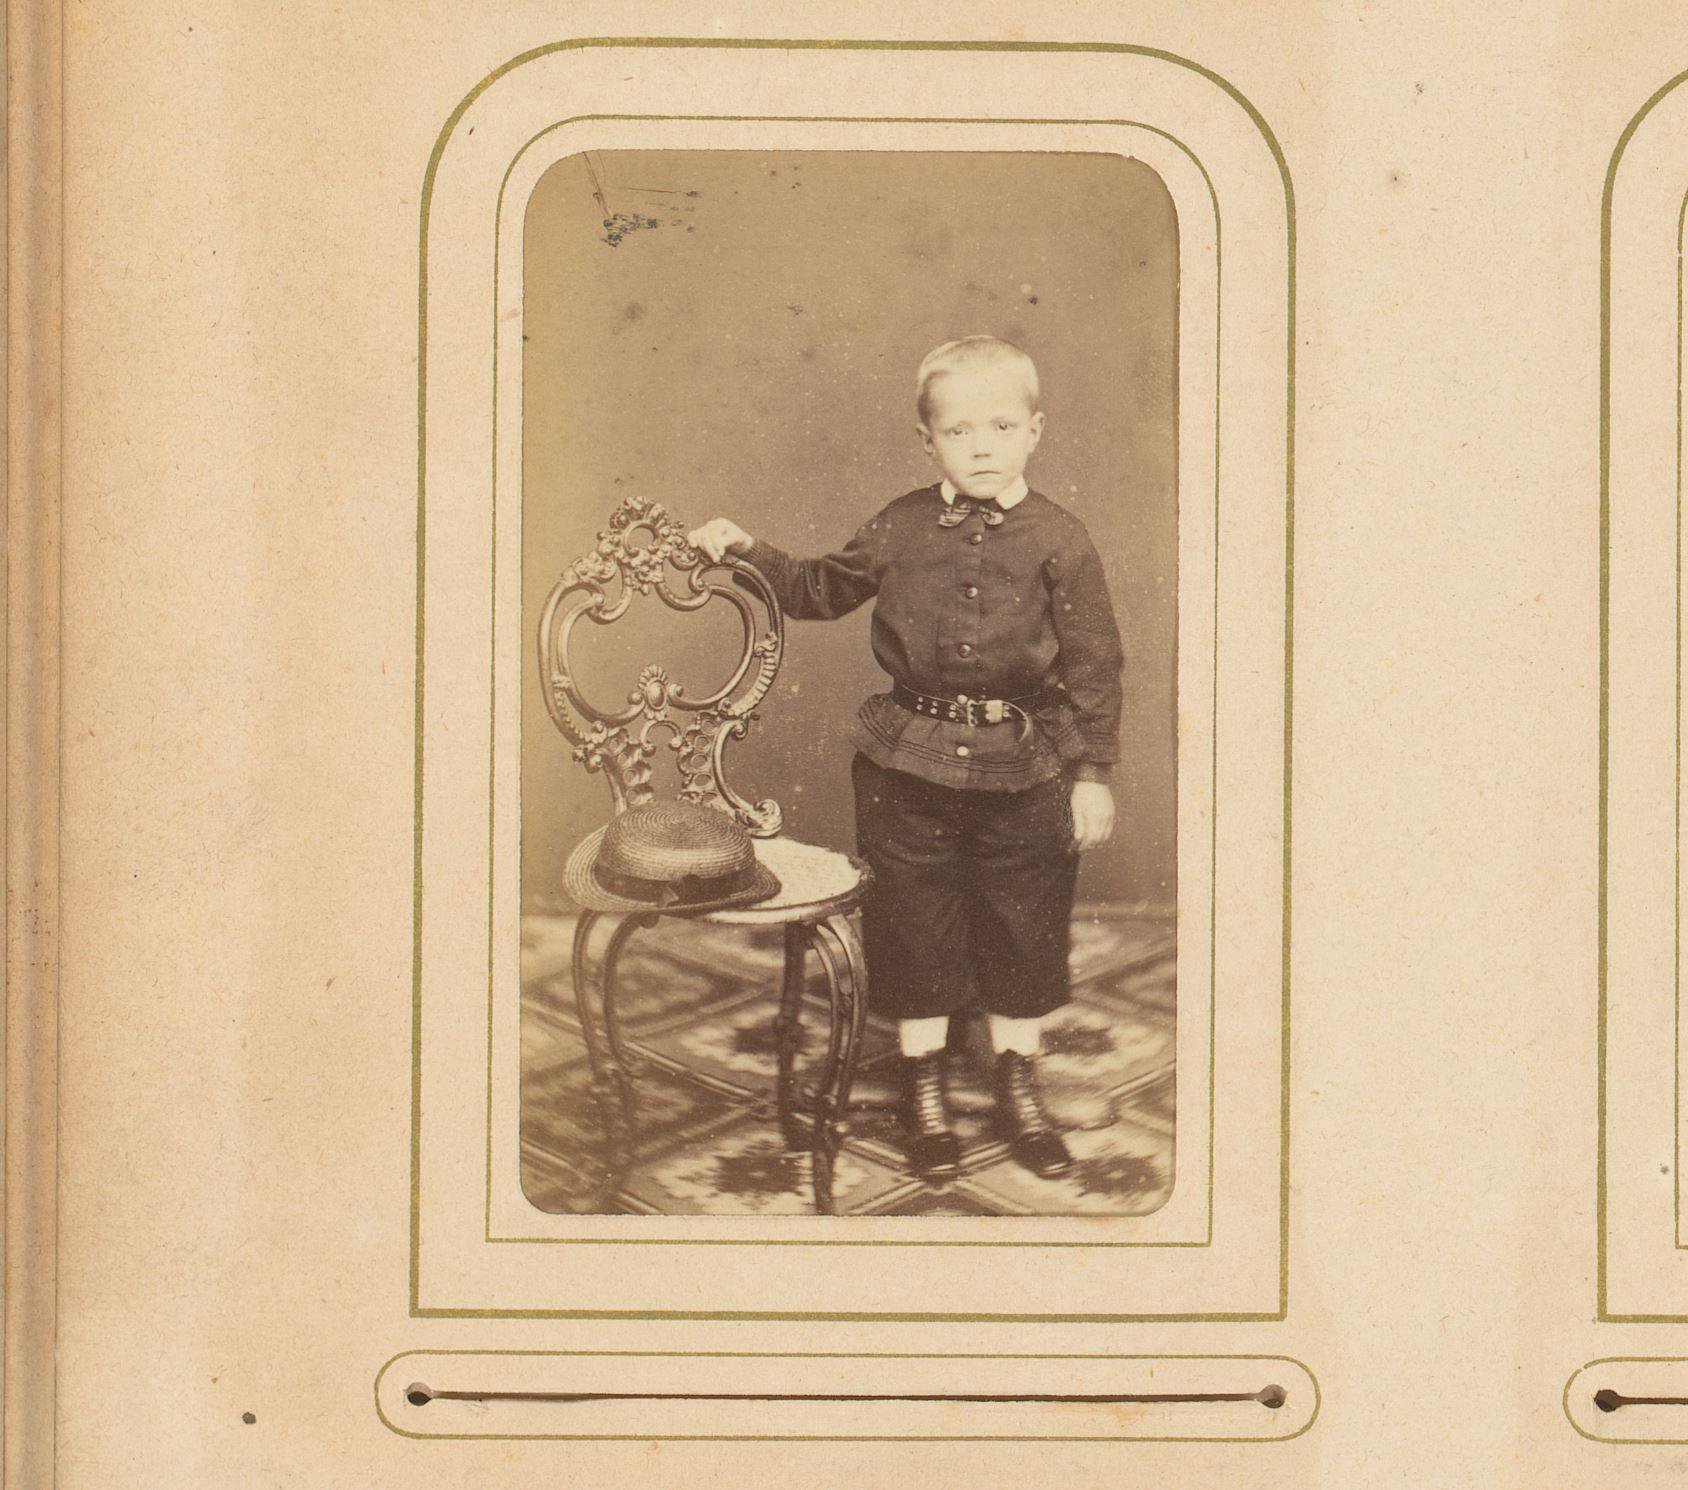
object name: album leaf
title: Portret van een jongen, staand bij een stoel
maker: gerarda henriëtte matthijssen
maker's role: draughtsman, painter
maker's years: 1830-1907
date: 1860-1900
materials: cardboard, photographic support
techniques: albumen print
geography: leeuwarden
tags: standing figure, boy (child between toddler and youth), historical persons, chair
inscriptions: inscription: ‘(...)/ Photographisch/ Atelier/ Mej. G. H. Matthijssen/ St Jacobstraat H 50./ Leeuwarden’